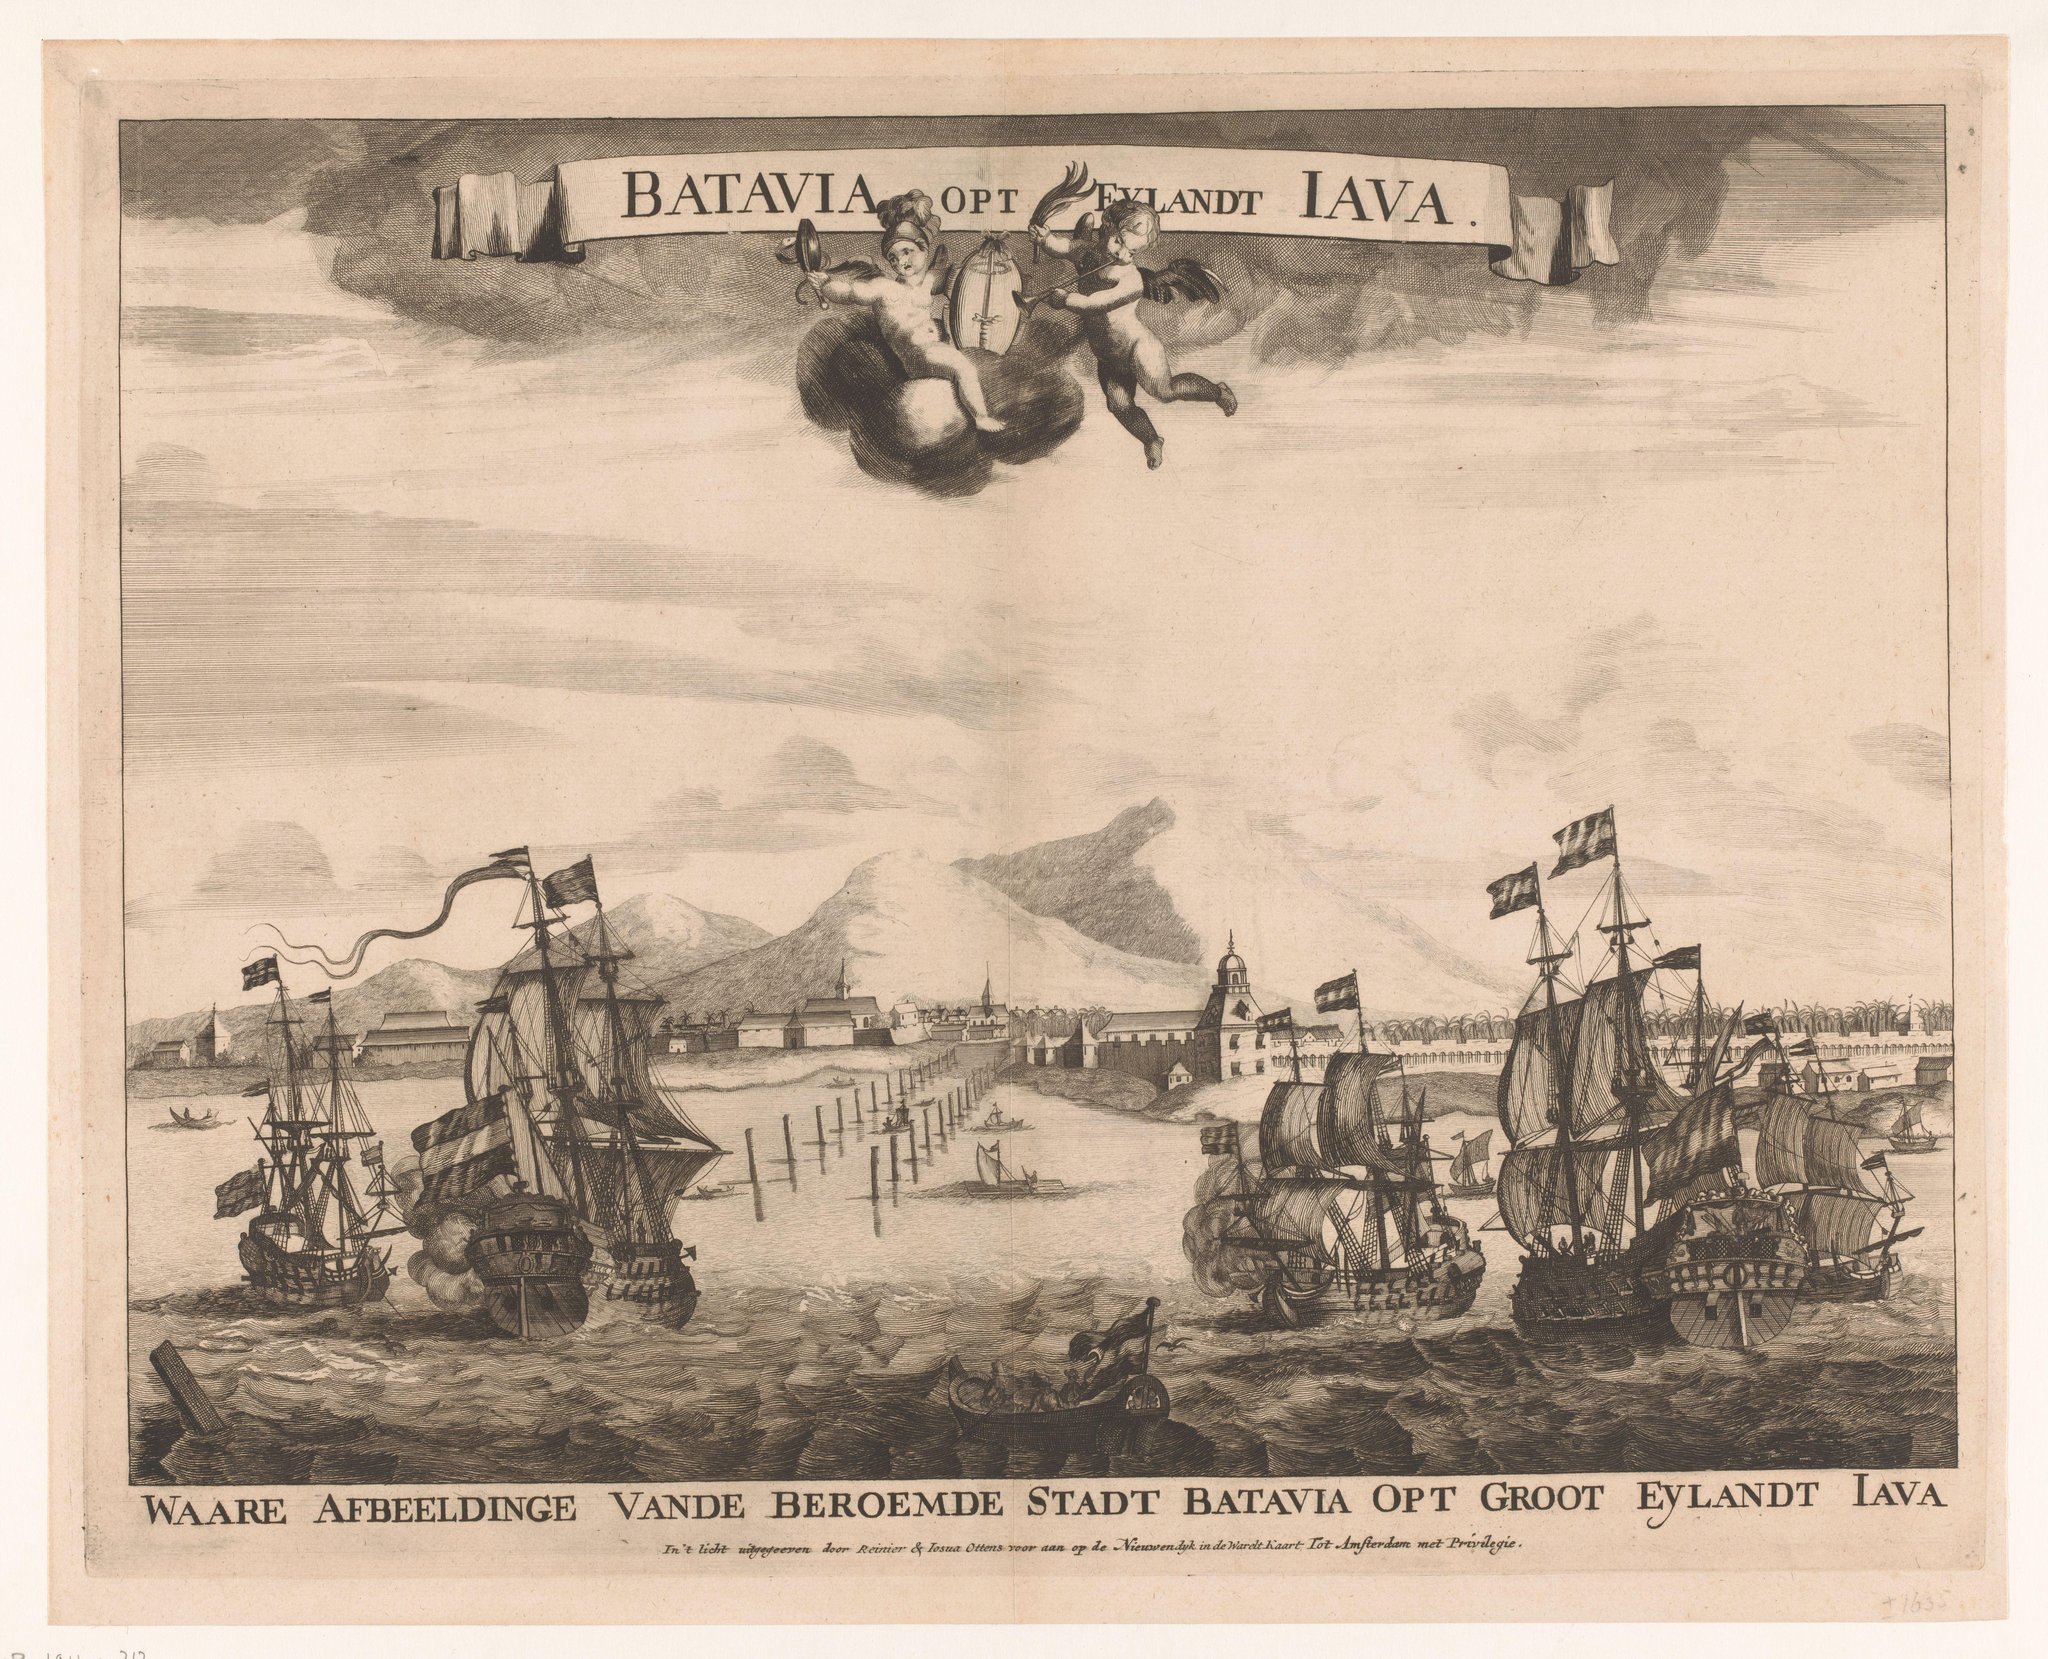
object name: print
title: Gezicht op Batavia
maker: Anonymous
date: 1726-1750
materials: paper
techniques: engraving, etching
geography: amsterdam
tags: island, ship in the roads, roadstead, batavia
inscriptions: collector's mark: Lugt 2228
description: Oost-Indiëvaarders op de rede voor Batavia, met enkele kleine vissersboten en een zeilvlot.